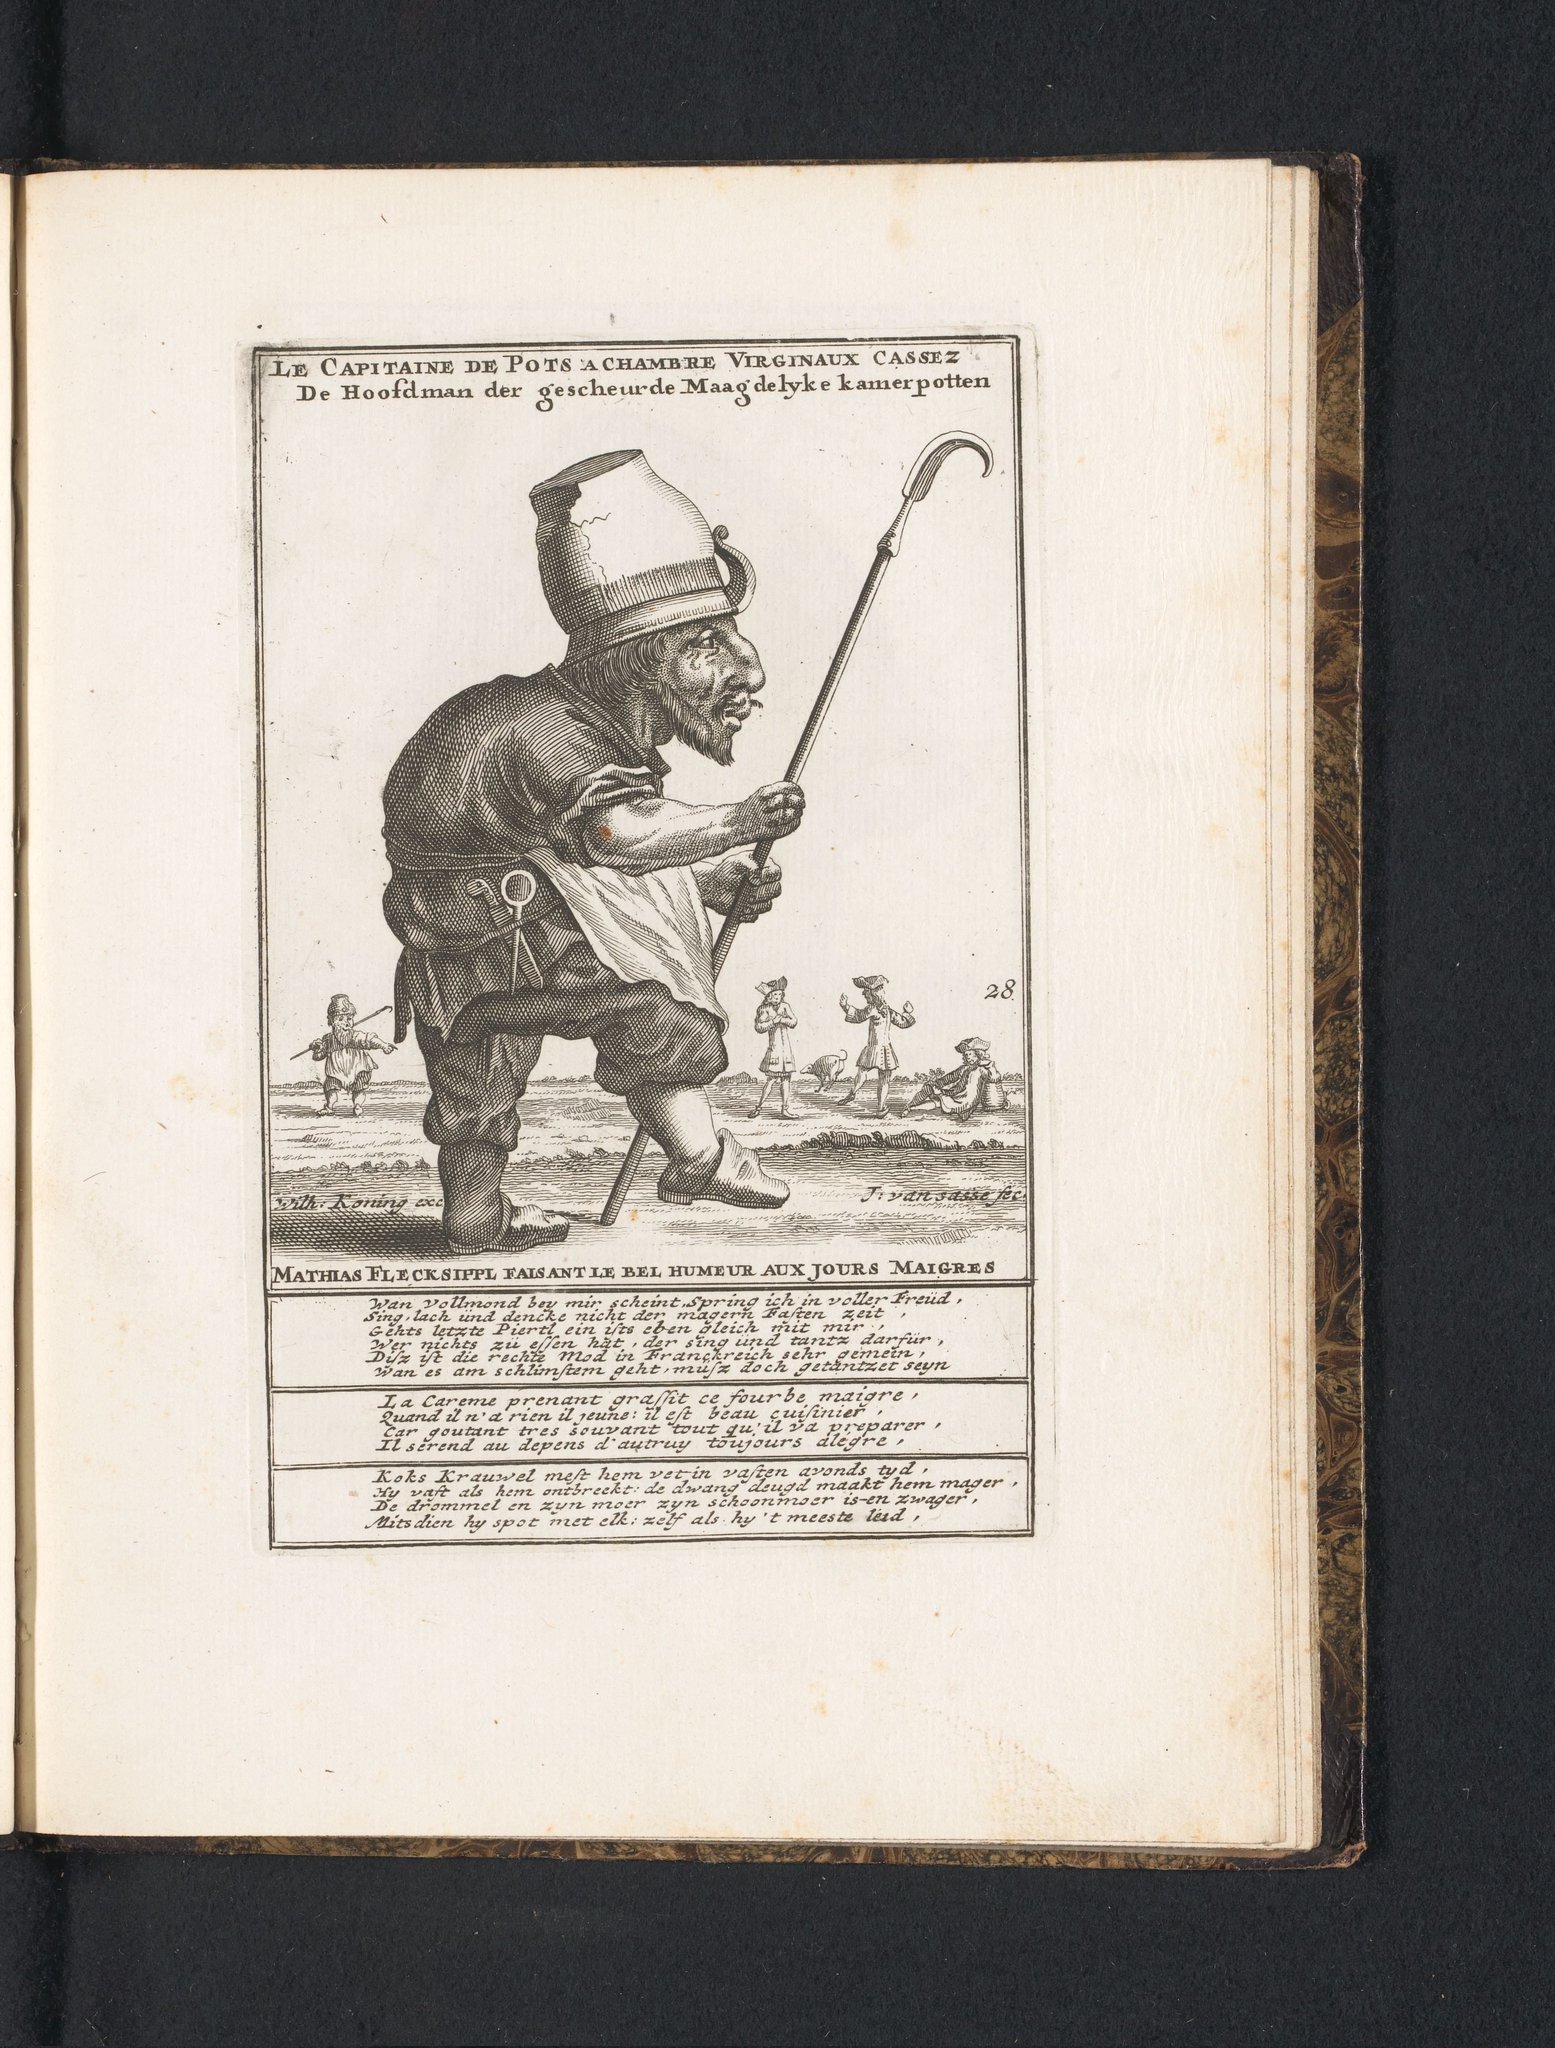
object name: print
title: De vrolijke kleine mens Hoofdman der gescheurde Maagdelyke kamperpotten, 1720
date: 1718-1720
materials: paper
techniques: etching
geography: northern netherlands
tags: caricatures (human types), little people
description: De vrolijke kleine mens Hoofdman der gescheurde Maagdelyke kamperpotten met herdersstaf en een aardewerken kruik op het hoofd. In het onderschrift verzen in het Duits, Frans en Nederlands. Genummerd rechts midden: 28. Onderdeel van deel II in de tweede Nederlandse gebonden uitgave uit 1720 (en gerelateerd aan de Windhandel in dat jaar) van een serie karikaturen van kleine mensen, bekend als Het Dwergentooneel.